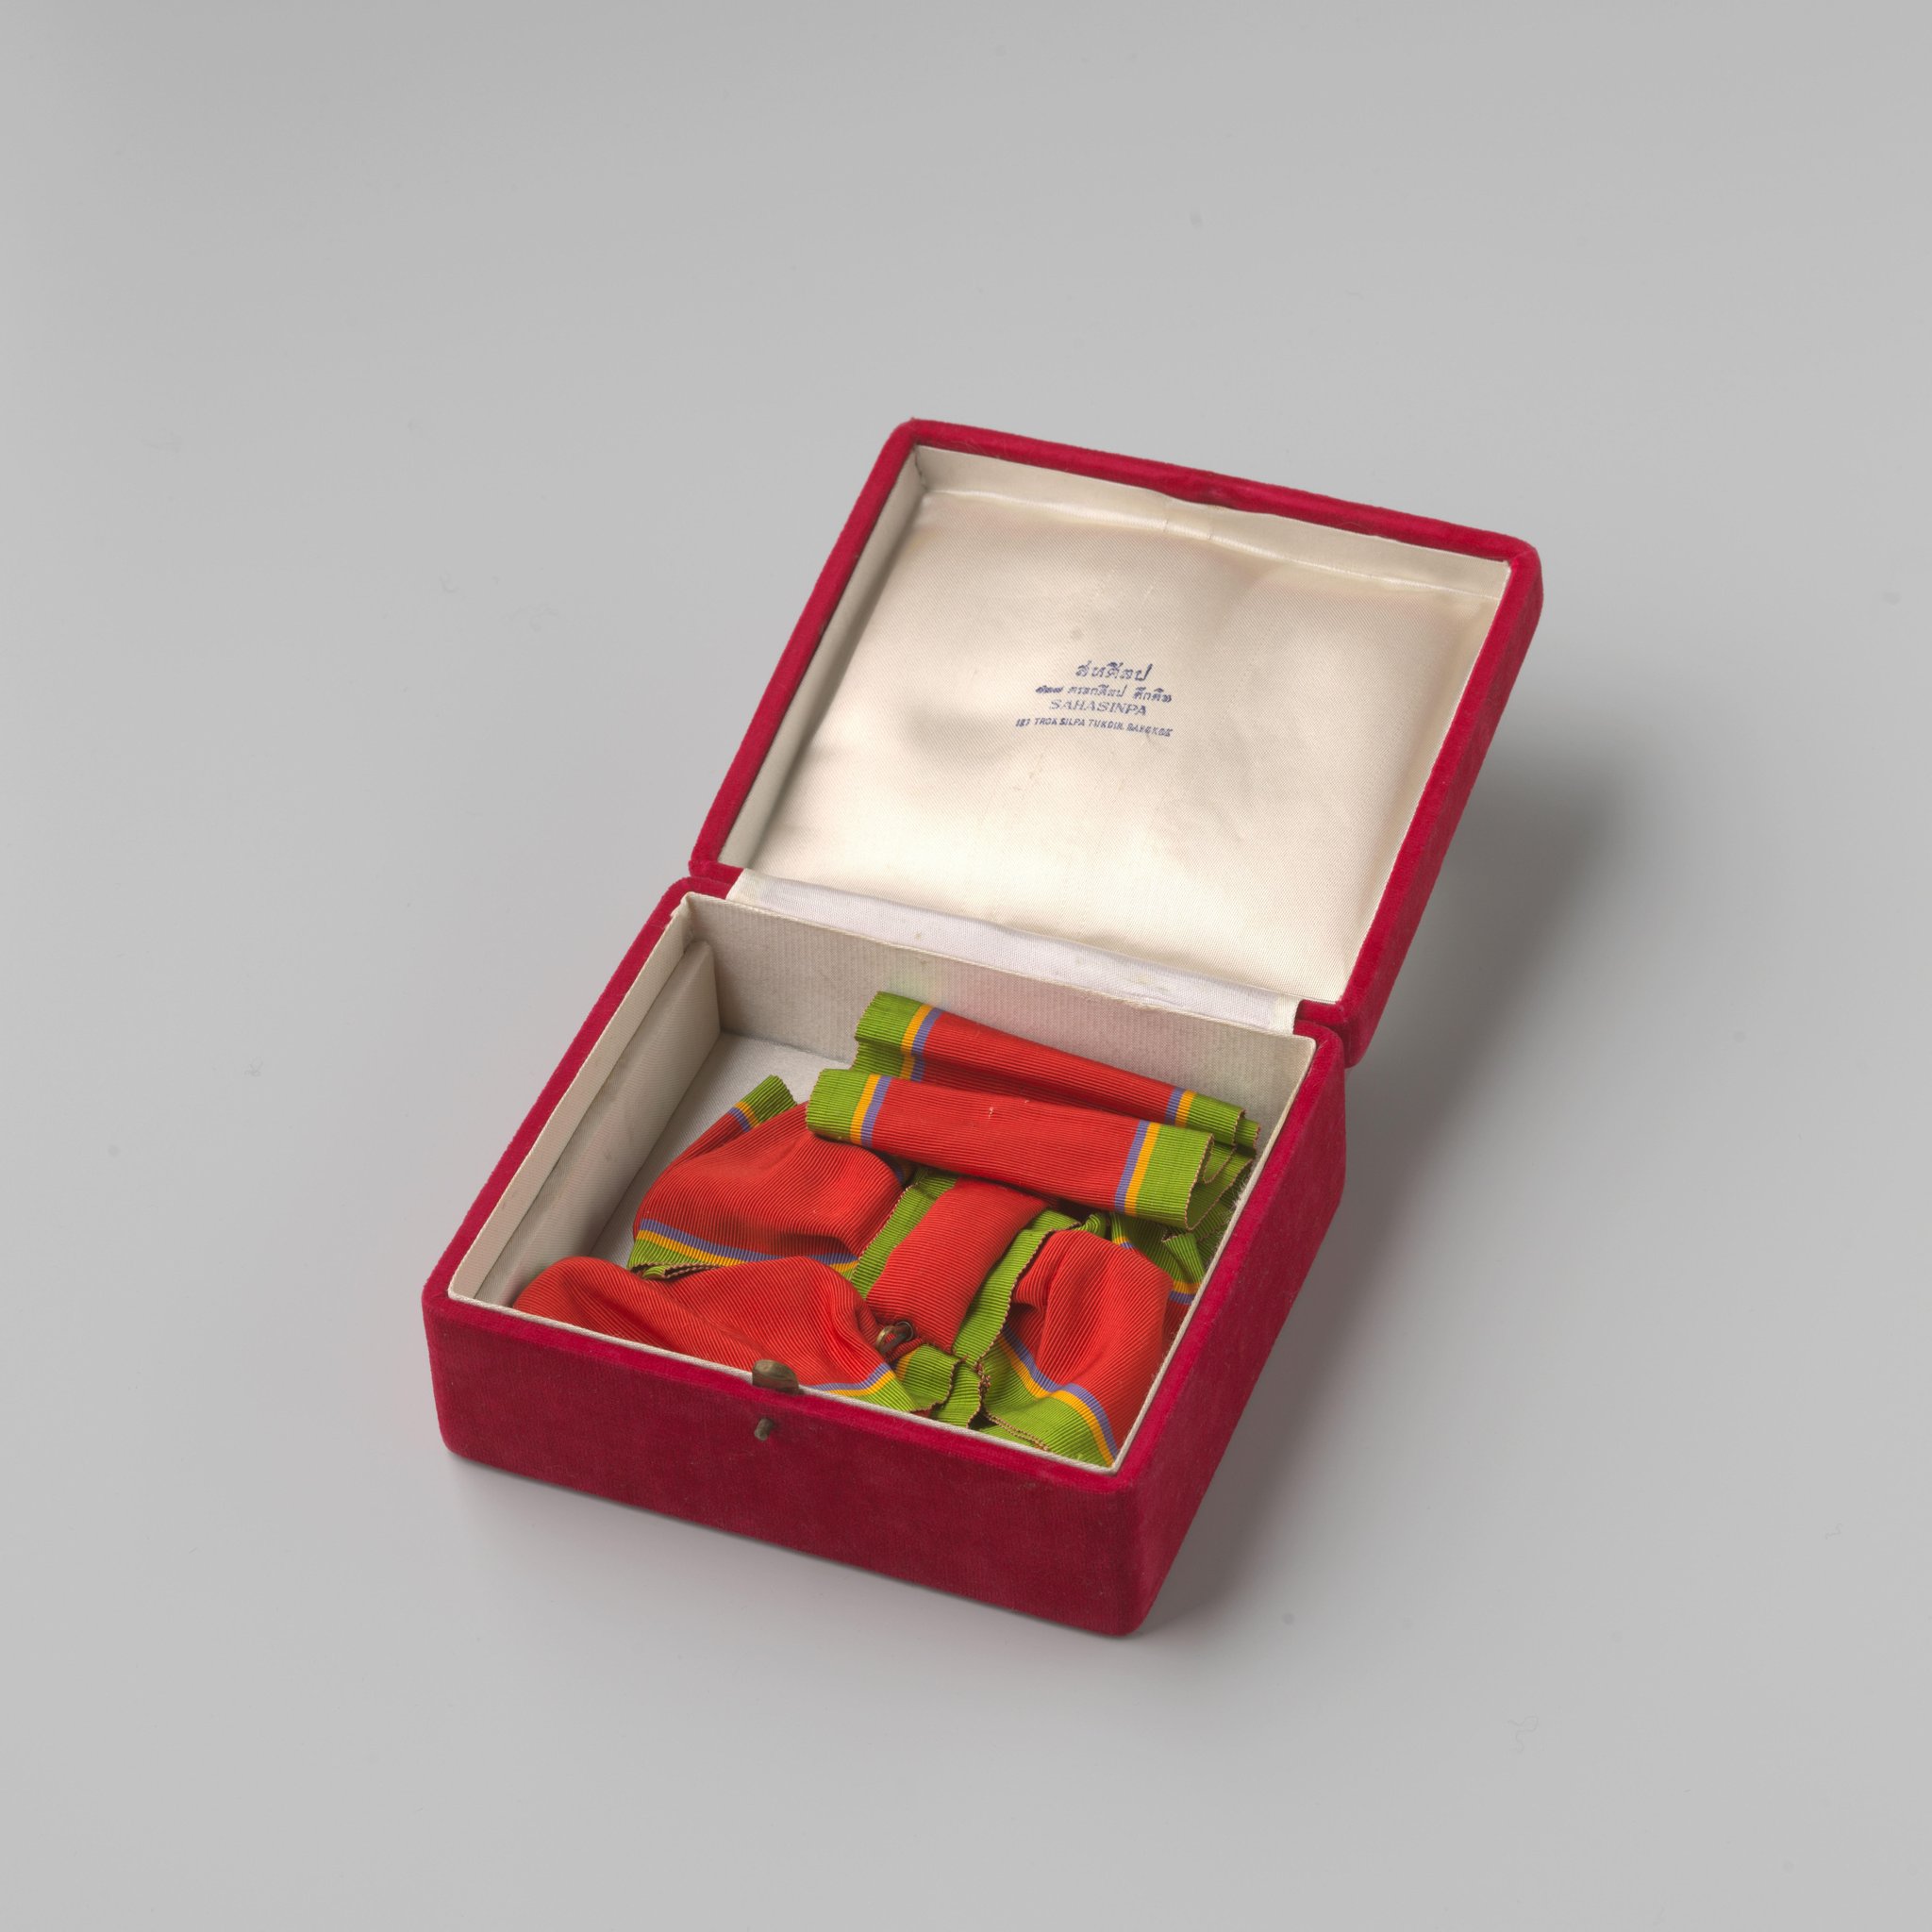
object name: bandolier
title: Een rode draagband met groene banden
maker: Anonymous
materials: textile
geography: bangkok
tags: amsterdam, the hague, willem drees, netherlands, thailand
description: De draagband bestaat uit een brede rode band met aan weerszijden twee smalle violette en gele banden en aan beide zijden begrensd door een wat minder smalle groene band; bij de aanhechting met het draagteken heeft de band de vorm van een strik.